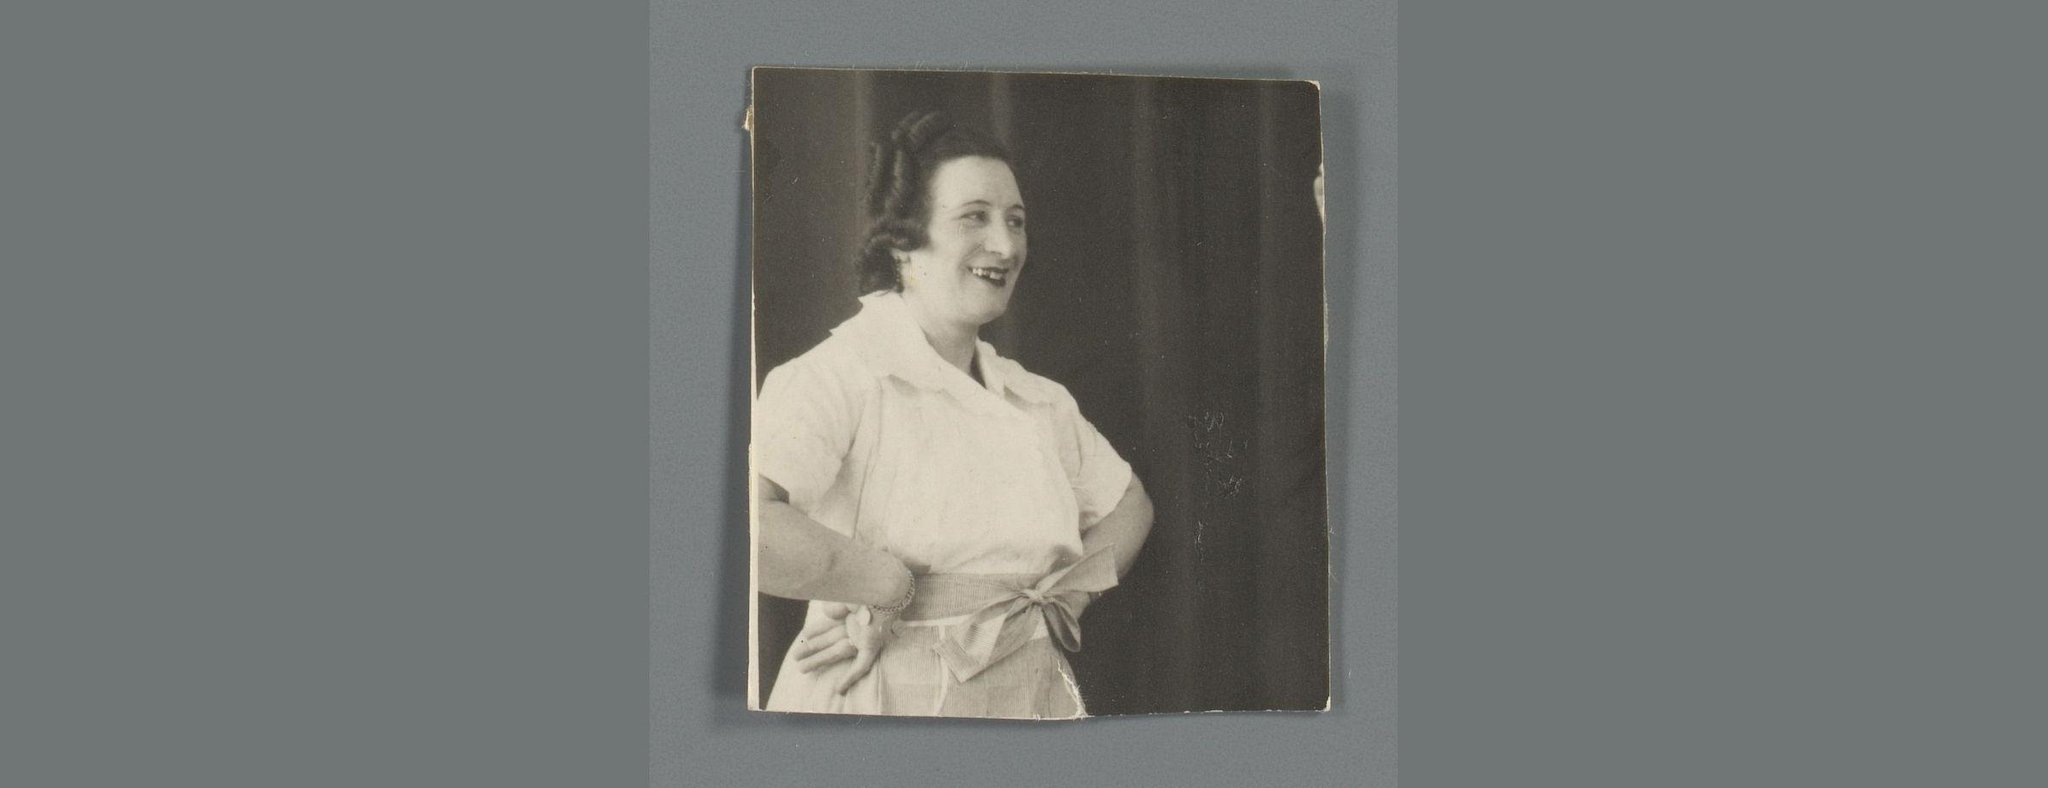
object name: photograph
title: Portret van Cato Merks met handen in de zij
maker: Anonymous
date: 1920-1940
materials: paper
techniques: gelatin silver print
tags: historical persons - bb - woman, hand on the hip - aa - both arms or hands, portrait of cabaret-artiste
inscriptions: inscription: ‘Cato Merks’